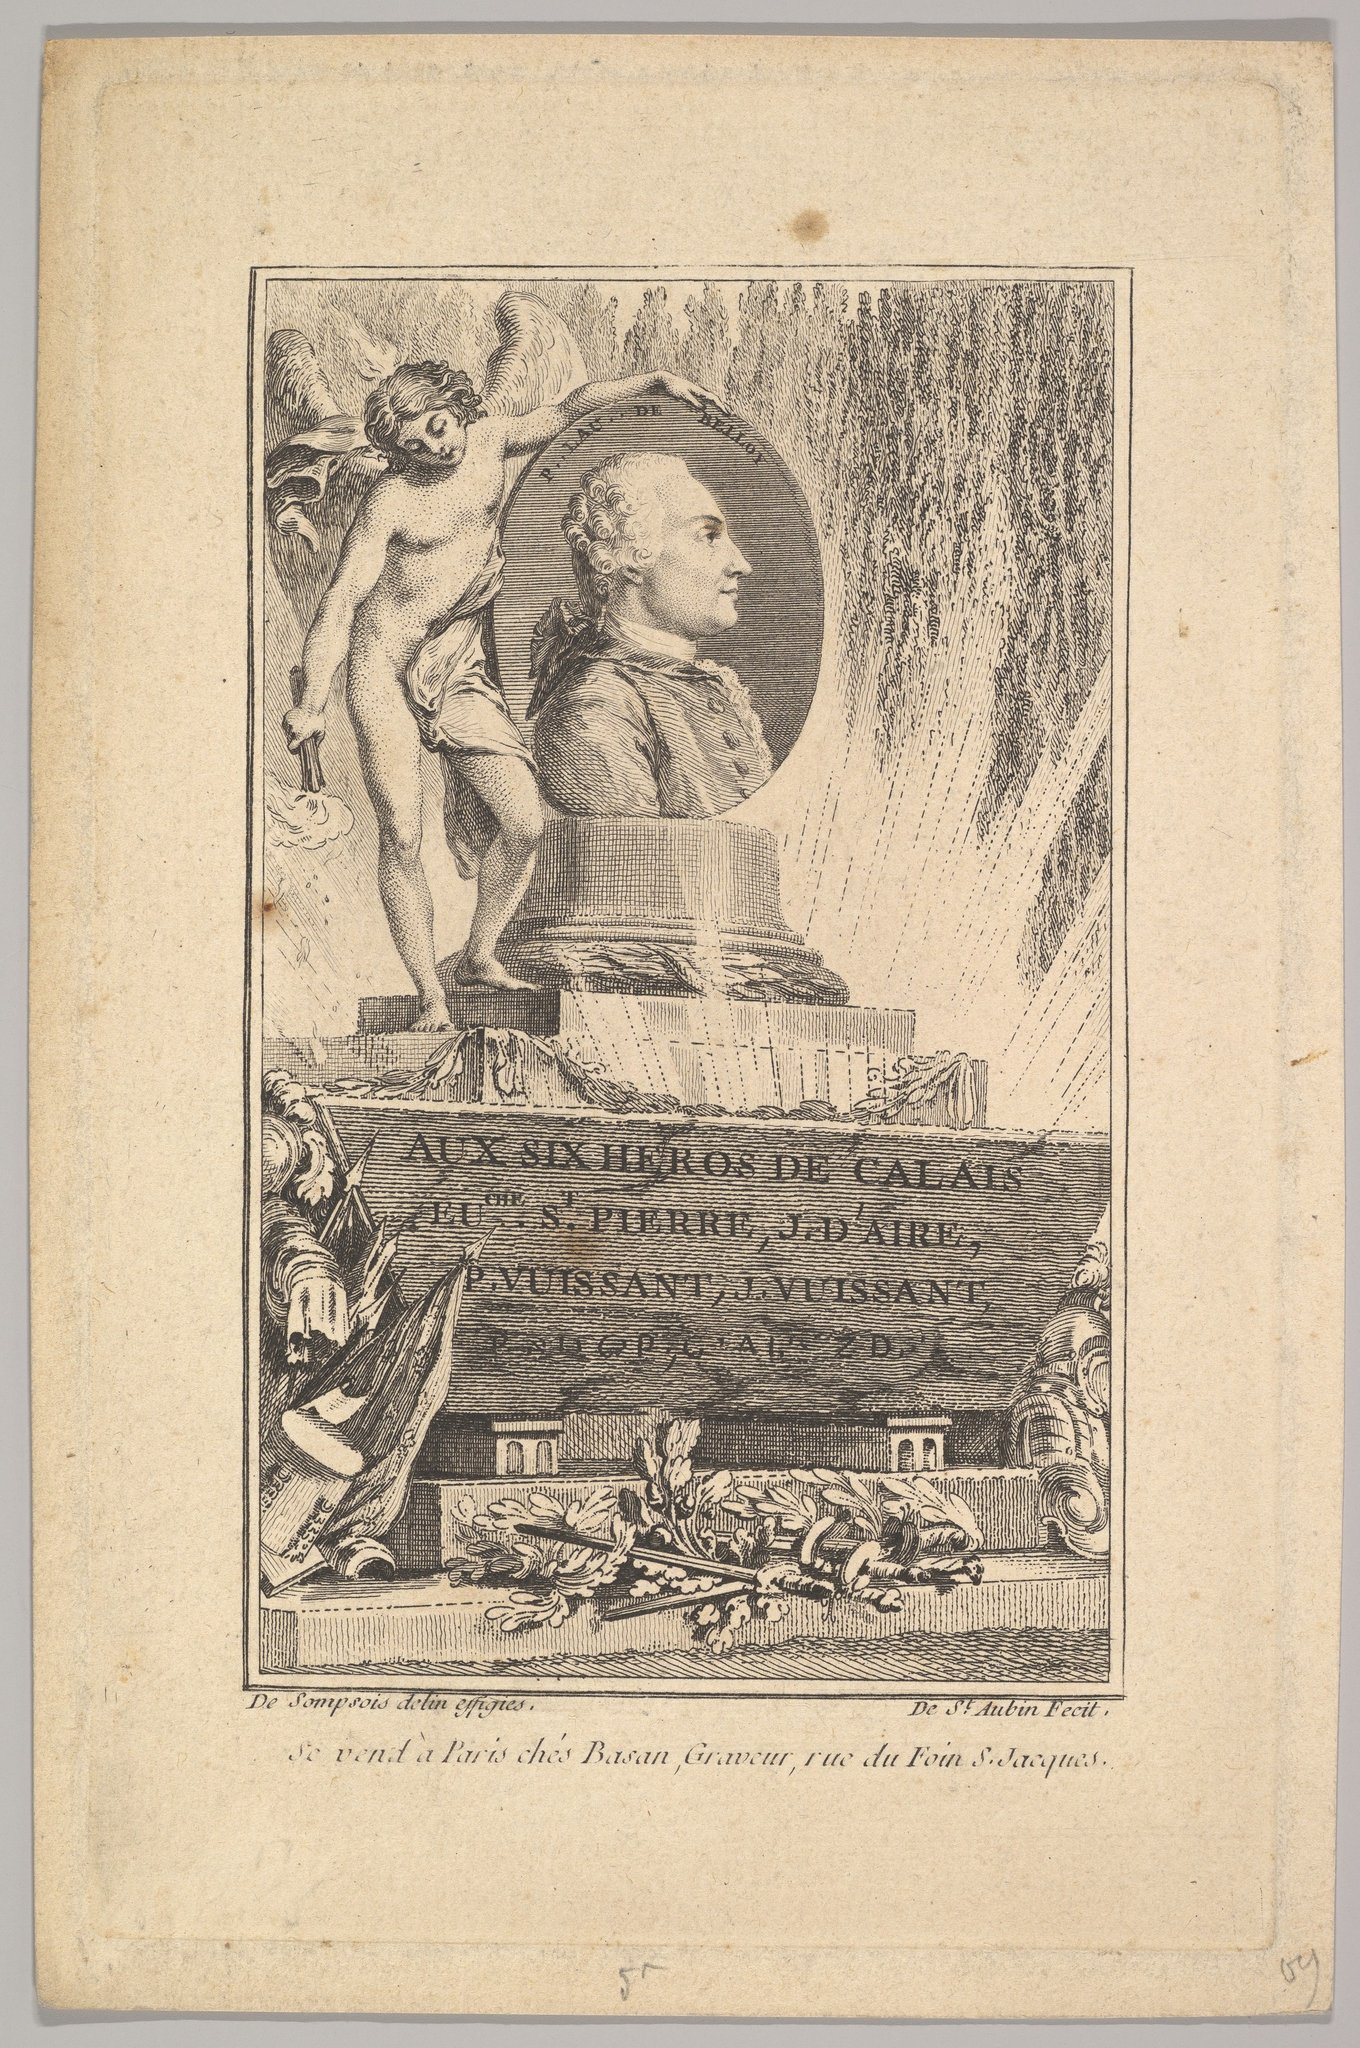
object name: print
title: Portrait of Pierre Laurent de Belloy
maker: augustin de saint-aubin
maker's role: artist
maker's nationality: french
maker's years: 1736-1807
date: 1765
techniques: engraving, etching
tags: men,profiles